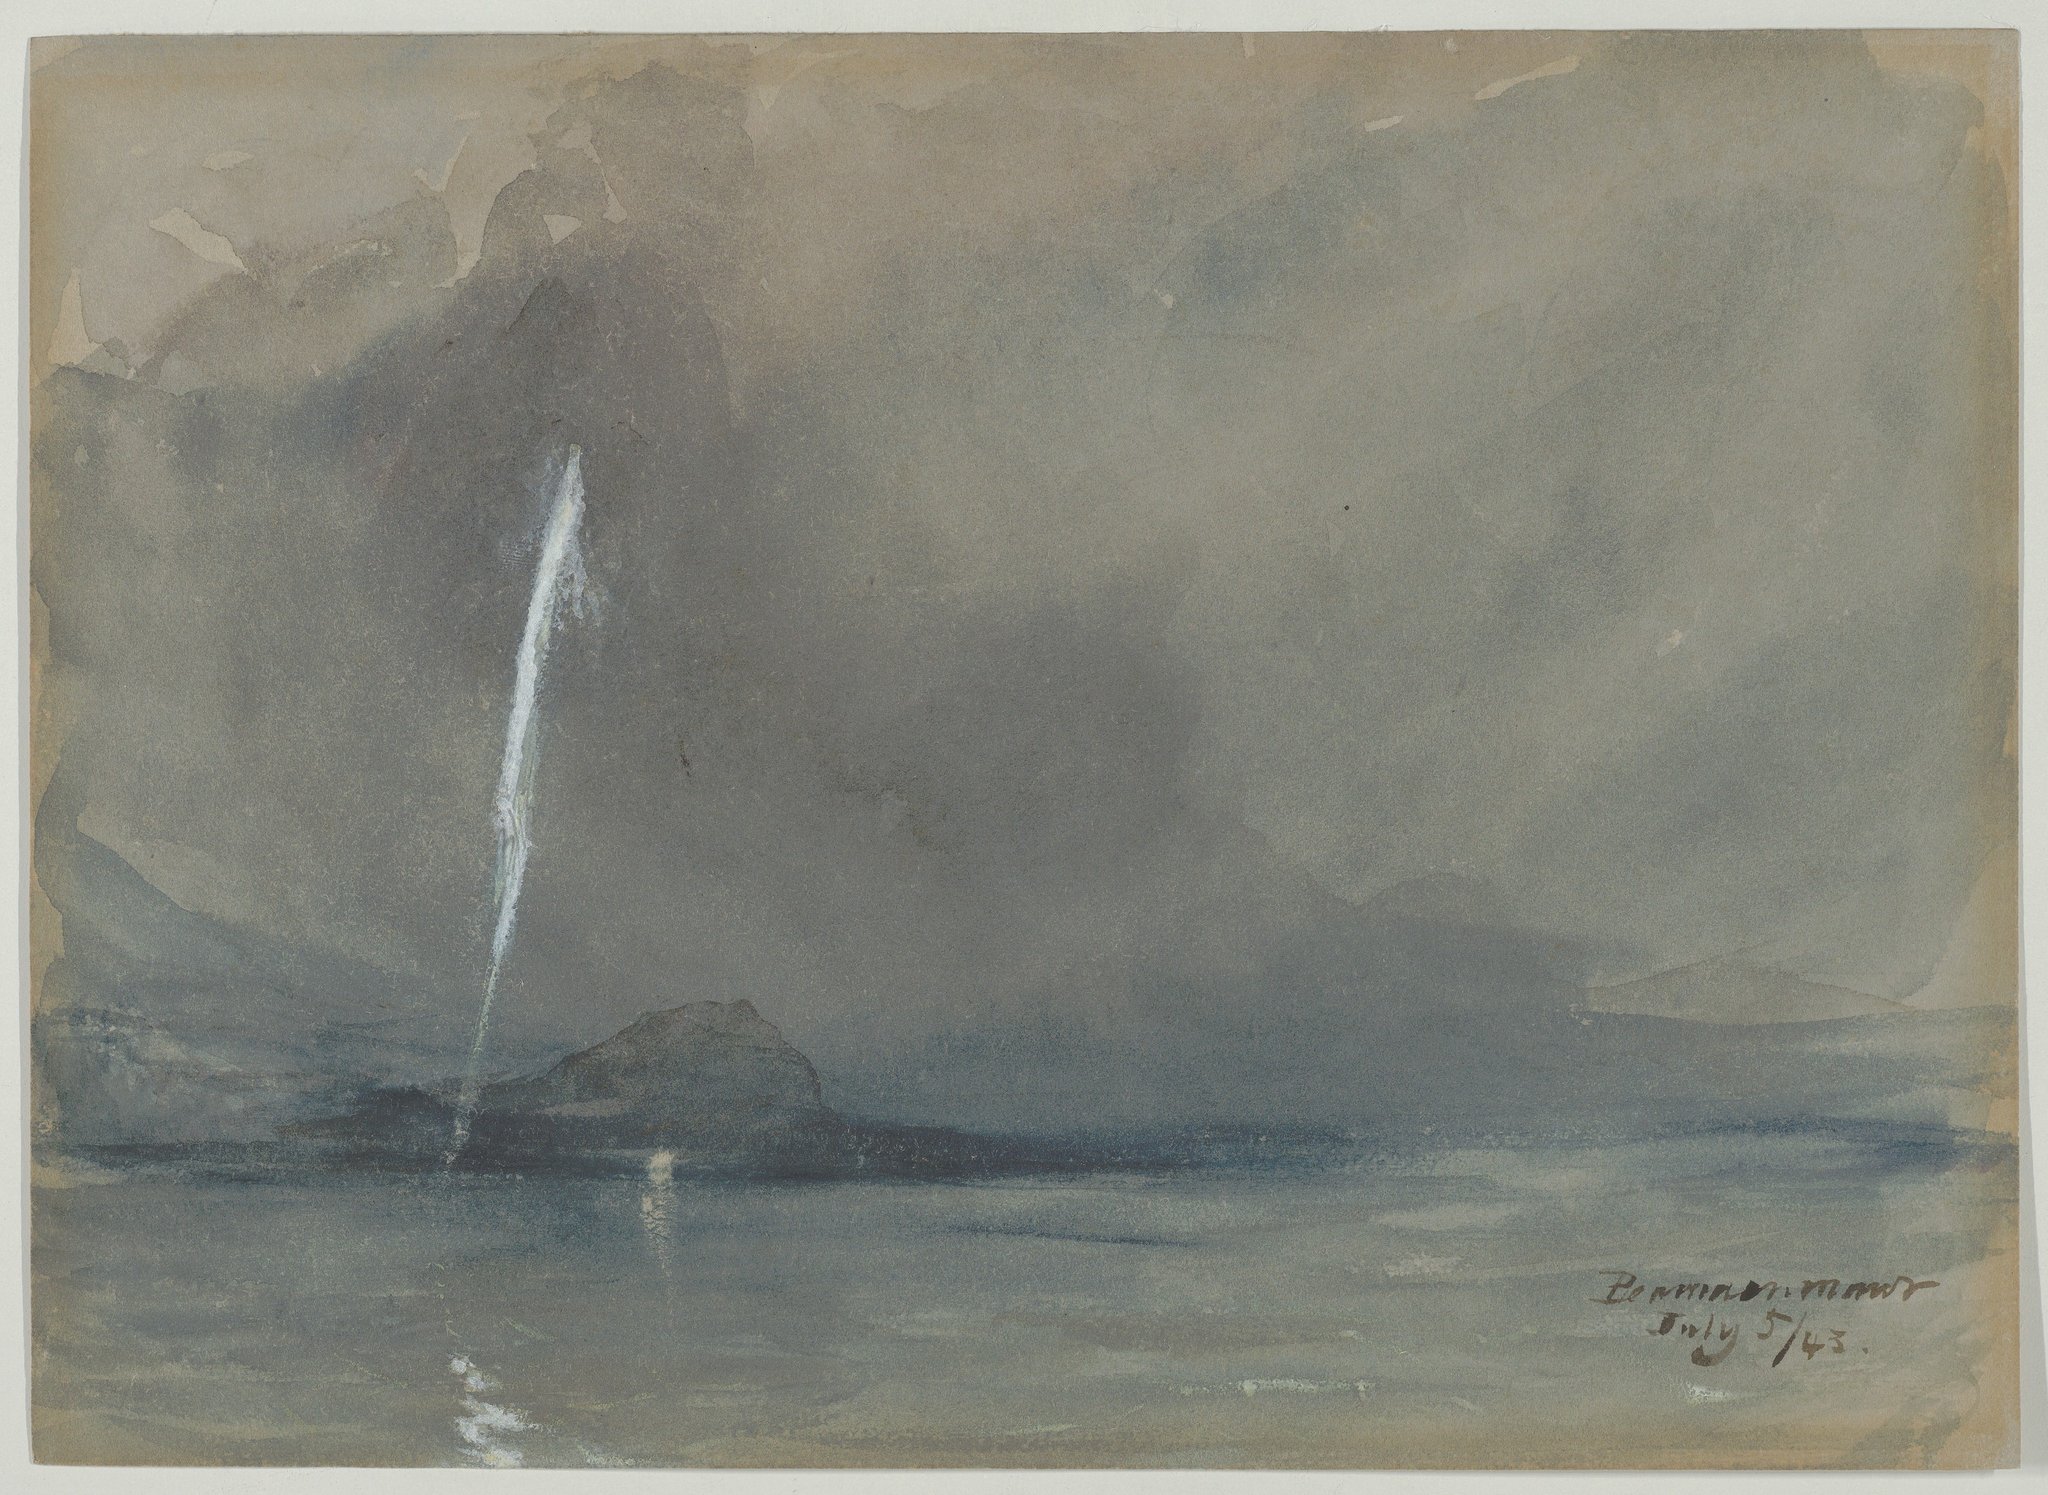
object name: drawing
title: Beaumaris Mount, near Bangor, Wales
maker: william collingwood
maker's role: artist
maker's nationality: british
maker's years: 1819-1903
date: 1843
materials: gouache, watercolor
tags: landscapes